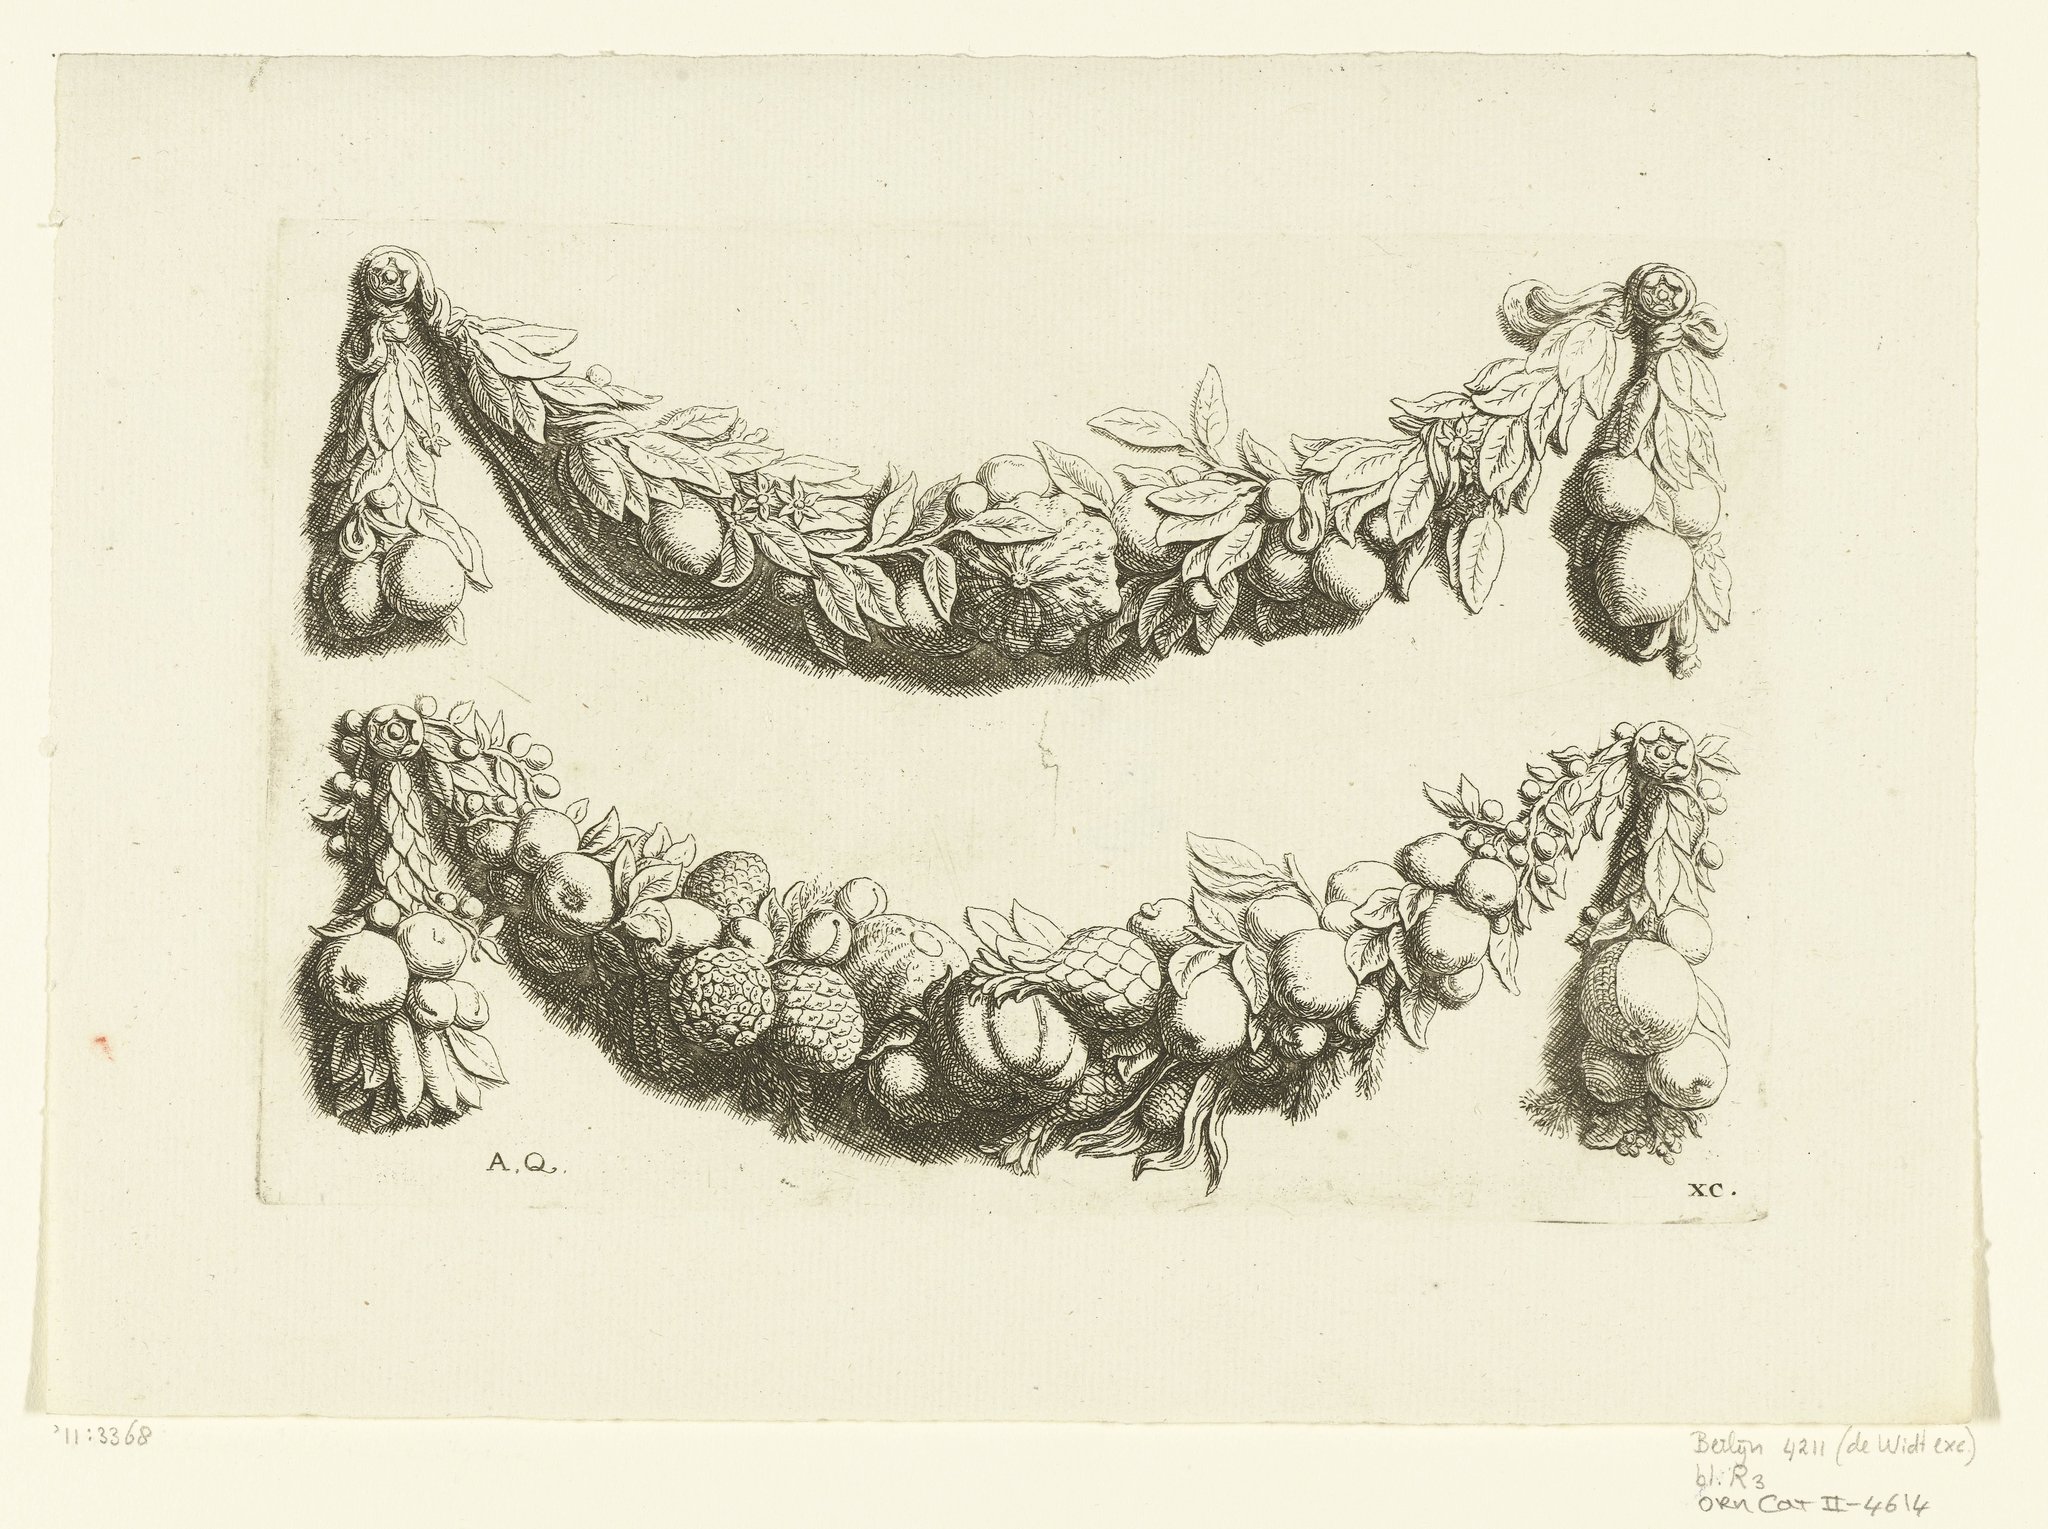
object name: print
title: Secunda Pars Praecipuarum (...)/Het tweede Deel Van de voornaemste Statuen ende Cieraten (...)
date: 1719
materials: paper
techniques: etching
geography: amsterdam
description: Blad XC. Blad R [3] in de edities van 1665 en 1668.